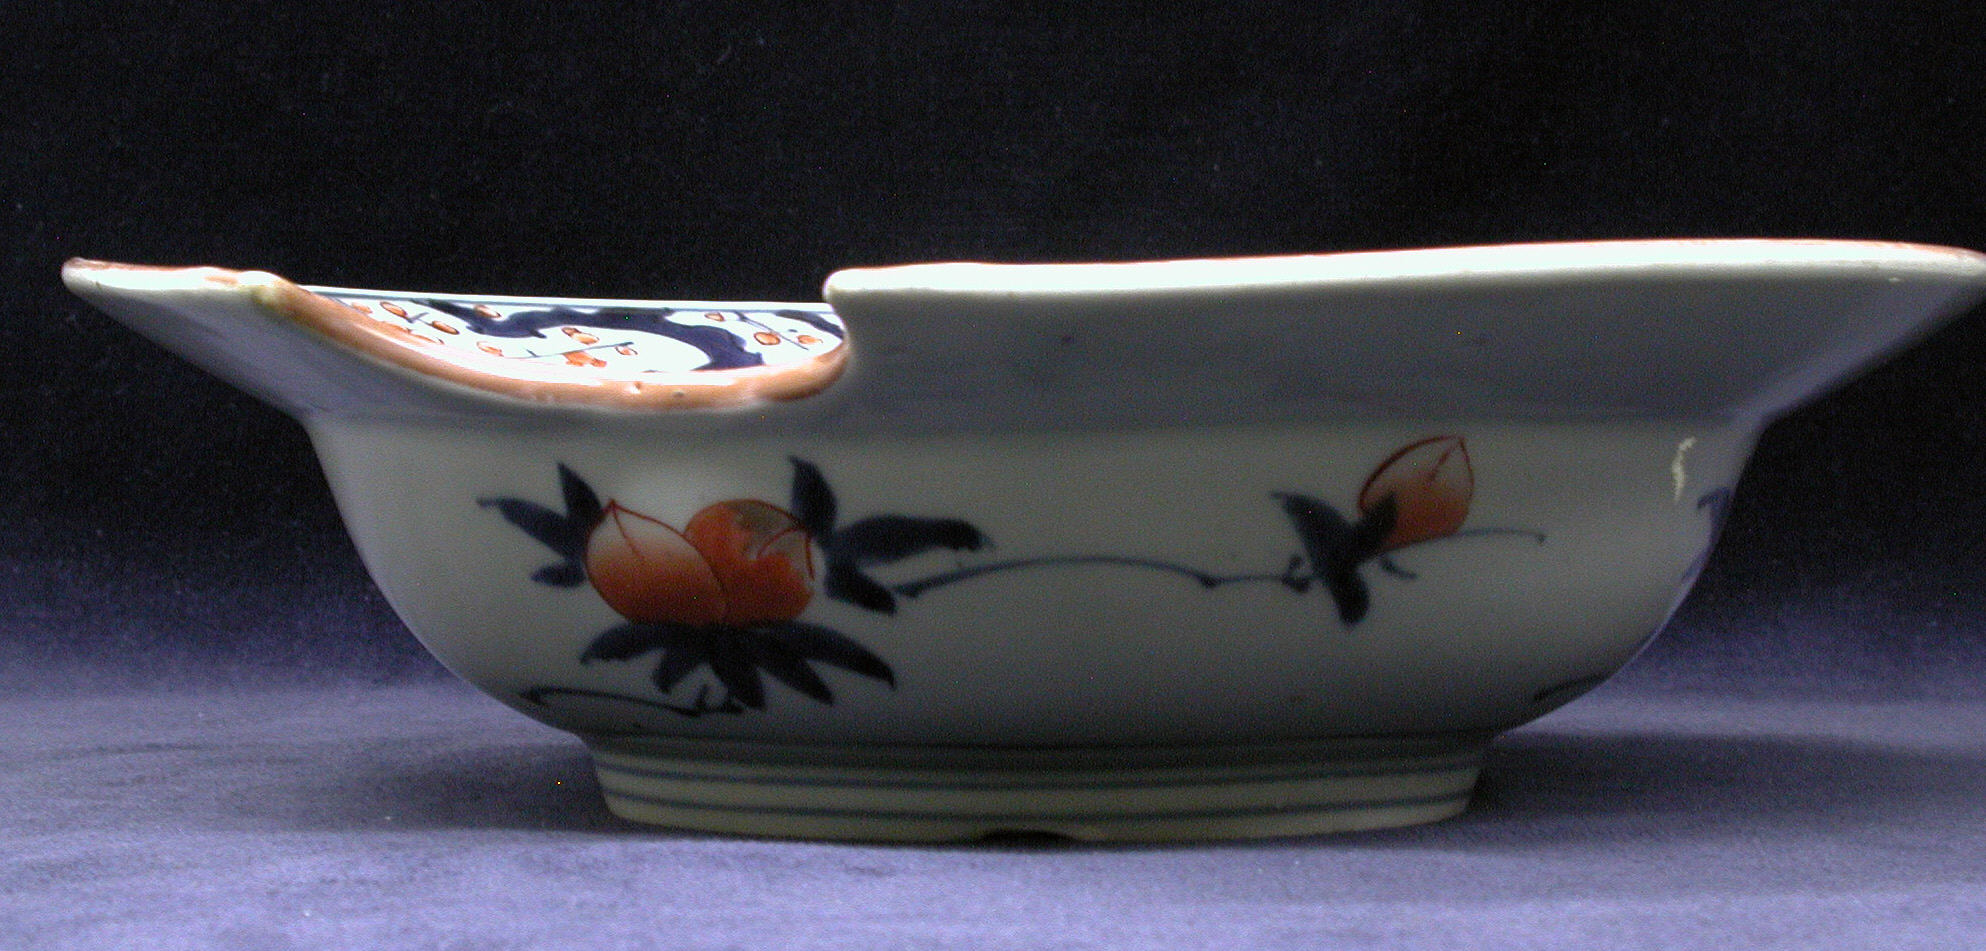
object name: barber's basin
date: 1740-1770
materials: hard paste porcelain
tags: fruit